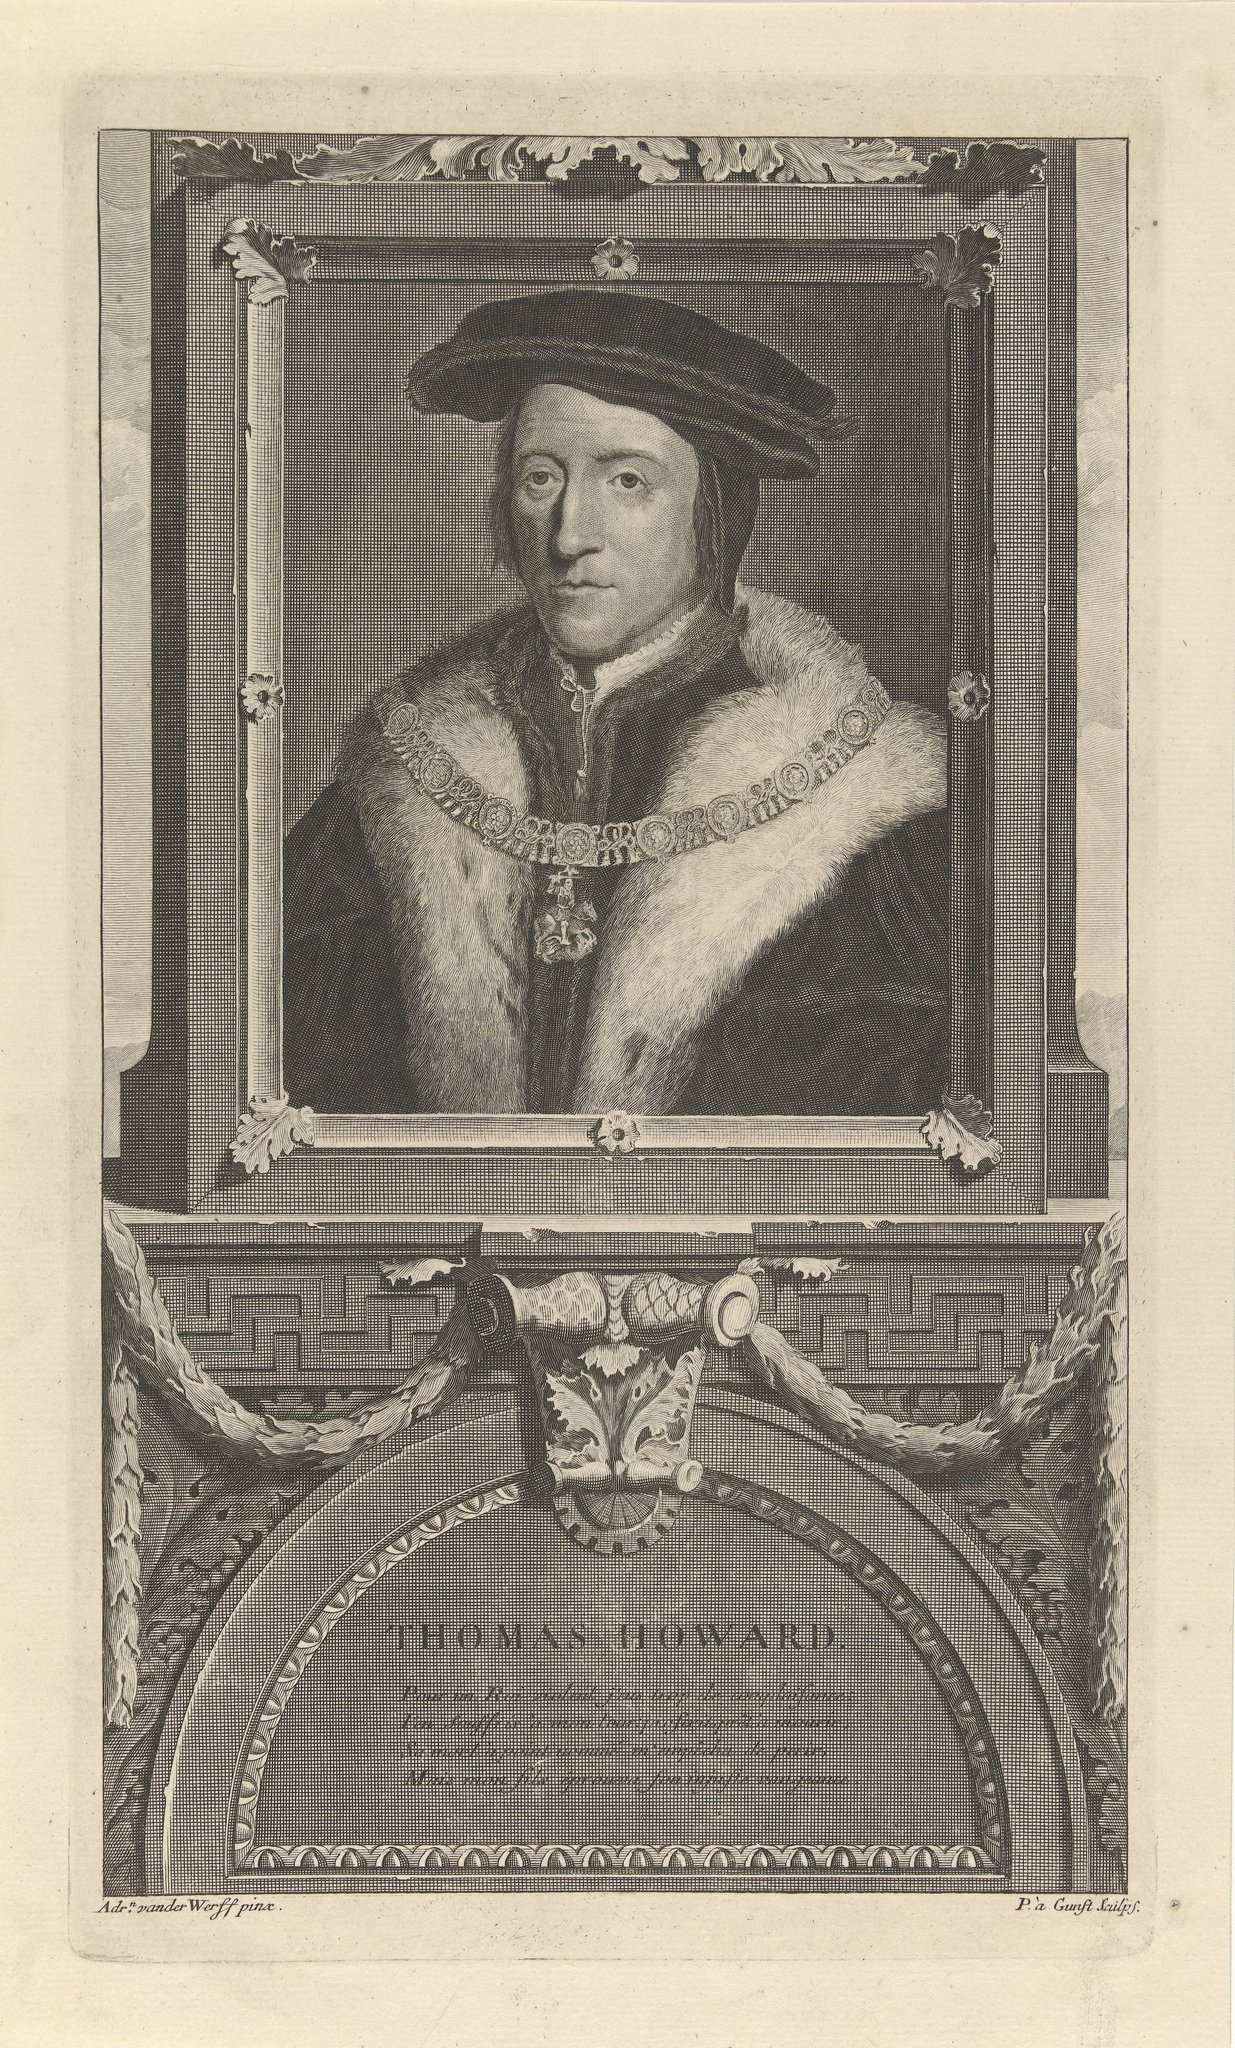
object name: print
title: Portret van Thomas Howard, graaf van Norfolk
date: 1669-1731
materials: paper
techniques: engraving, etching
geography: amsterdam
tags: politician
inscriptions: collector's mark: Lugt 2228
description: Thomas Howard, de graaf van Norfolk en voorzitter van de koninklijke raad van Engeland gedurende de regeringsperiode van Hendrik VIII. De prent heeft als onderschrift een Frans gedicht over zijn relatie met Hendrik VIII.